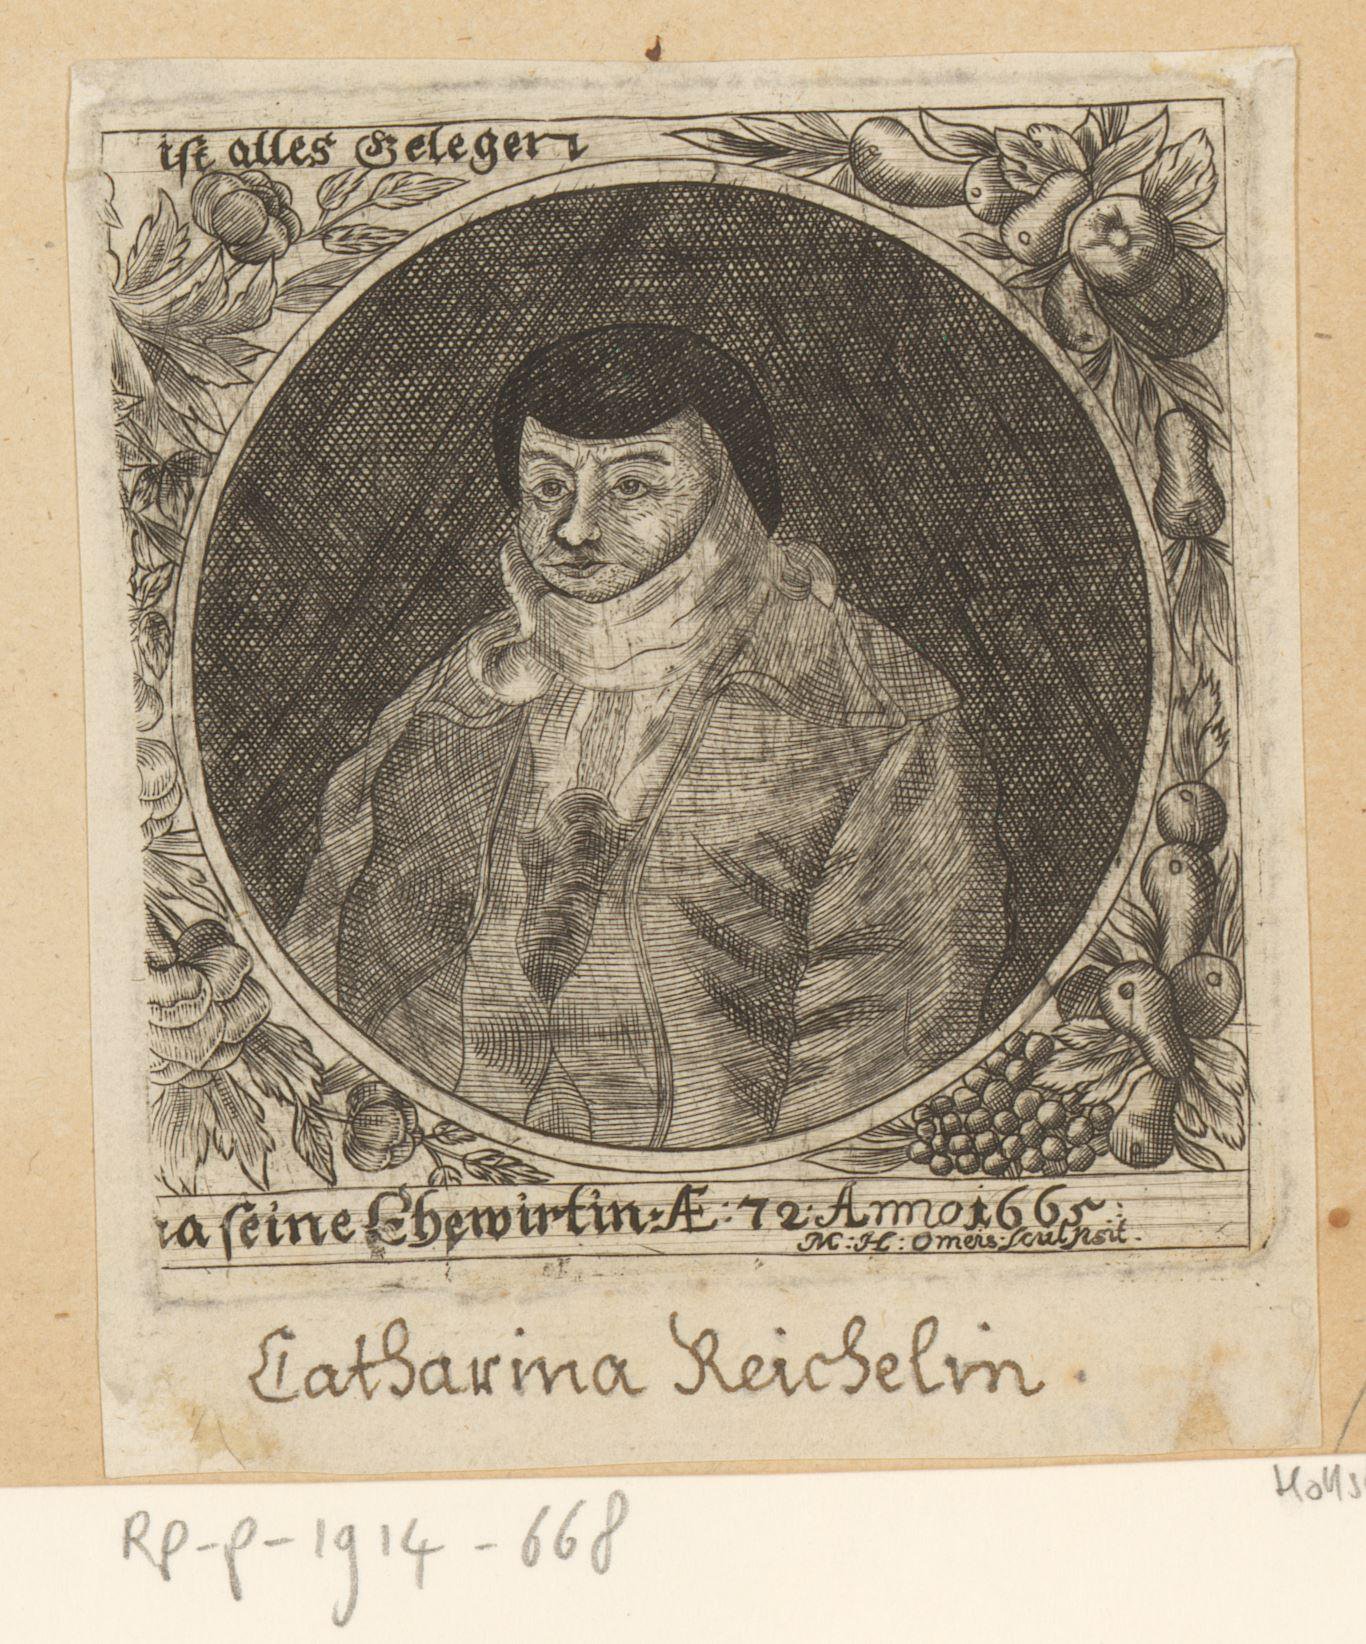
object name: print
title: Portret van Catharina Reichel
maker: martin heinrich omeis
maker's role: print maker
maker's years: 1650-1703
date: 1660-1703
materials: paper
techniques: engraving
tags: plants; vegetation, historical persons - bb - woman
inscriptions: collector's mark: Lugt 2228, name: ‘Catharina Reichelm’